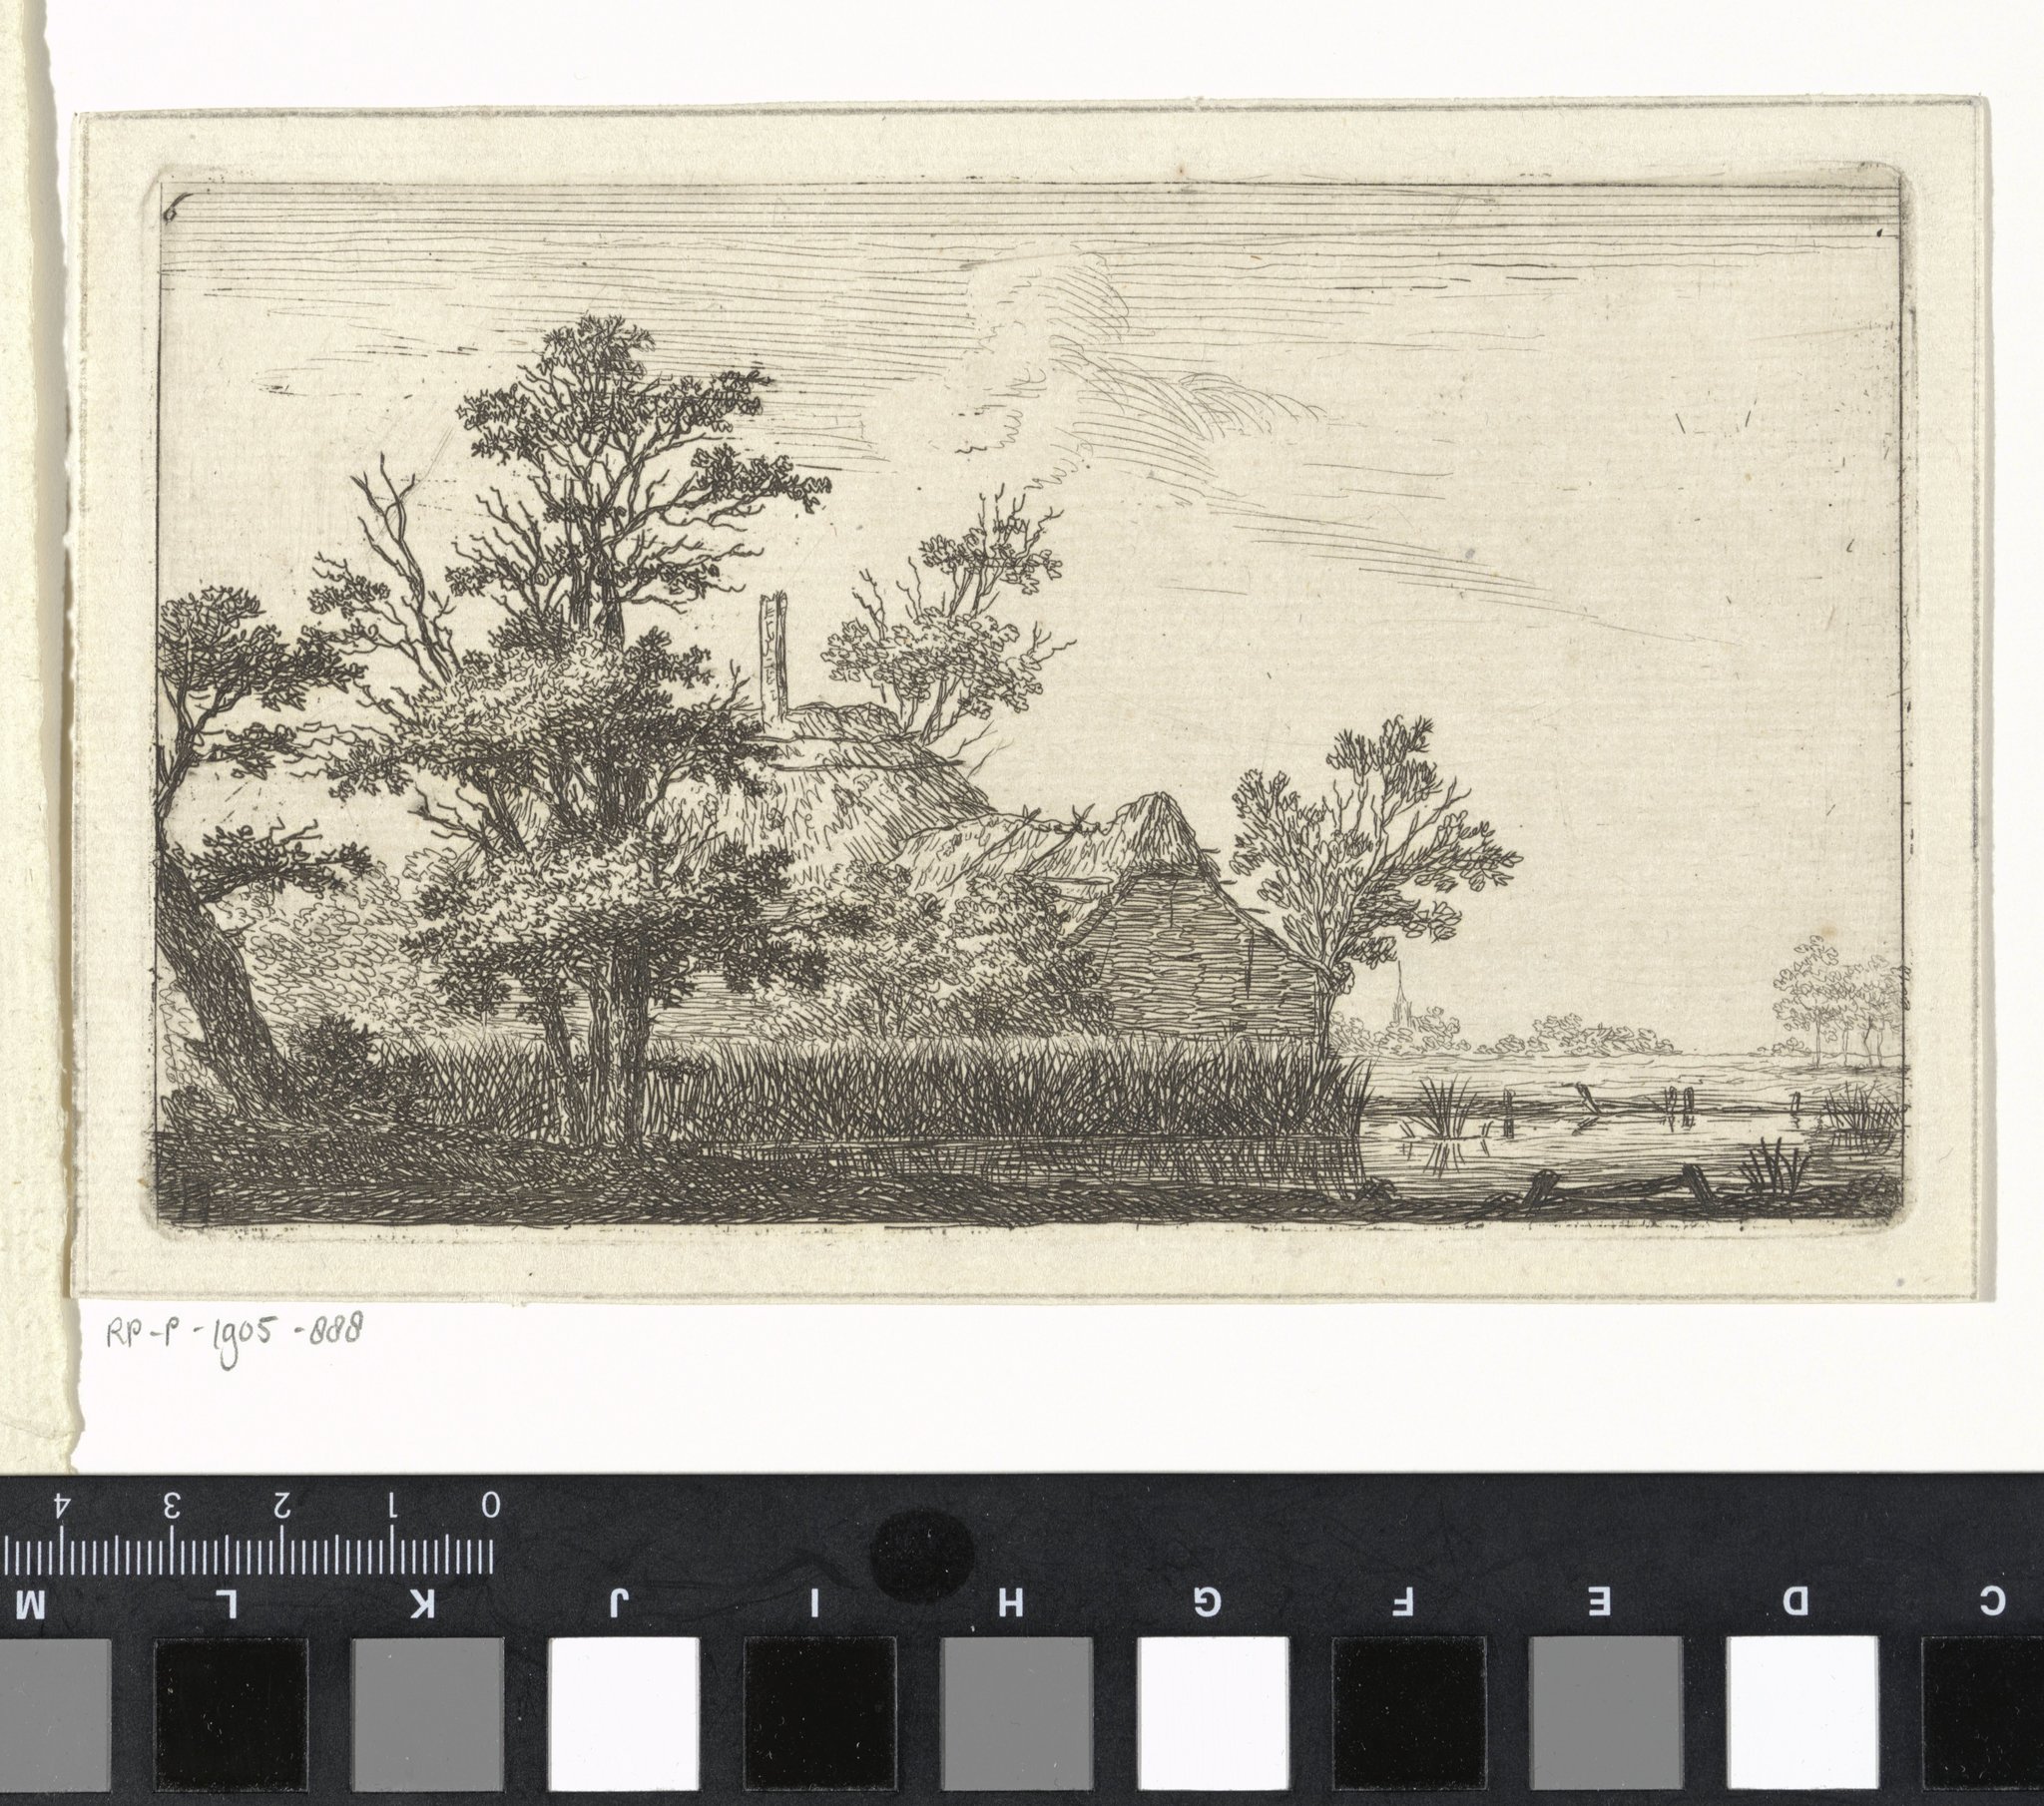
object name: print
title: Boerderij aan het water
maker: hendrik schwegman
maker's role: draughtsman, print maker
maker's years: 1761-1816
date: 1786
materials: paper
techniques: engraving, etching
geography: haarlem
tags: farm or solitary house in landscape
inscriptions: collector's mark: Lugt 2228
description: Boerderij aan het water met op de voorgrond een rietkraag.